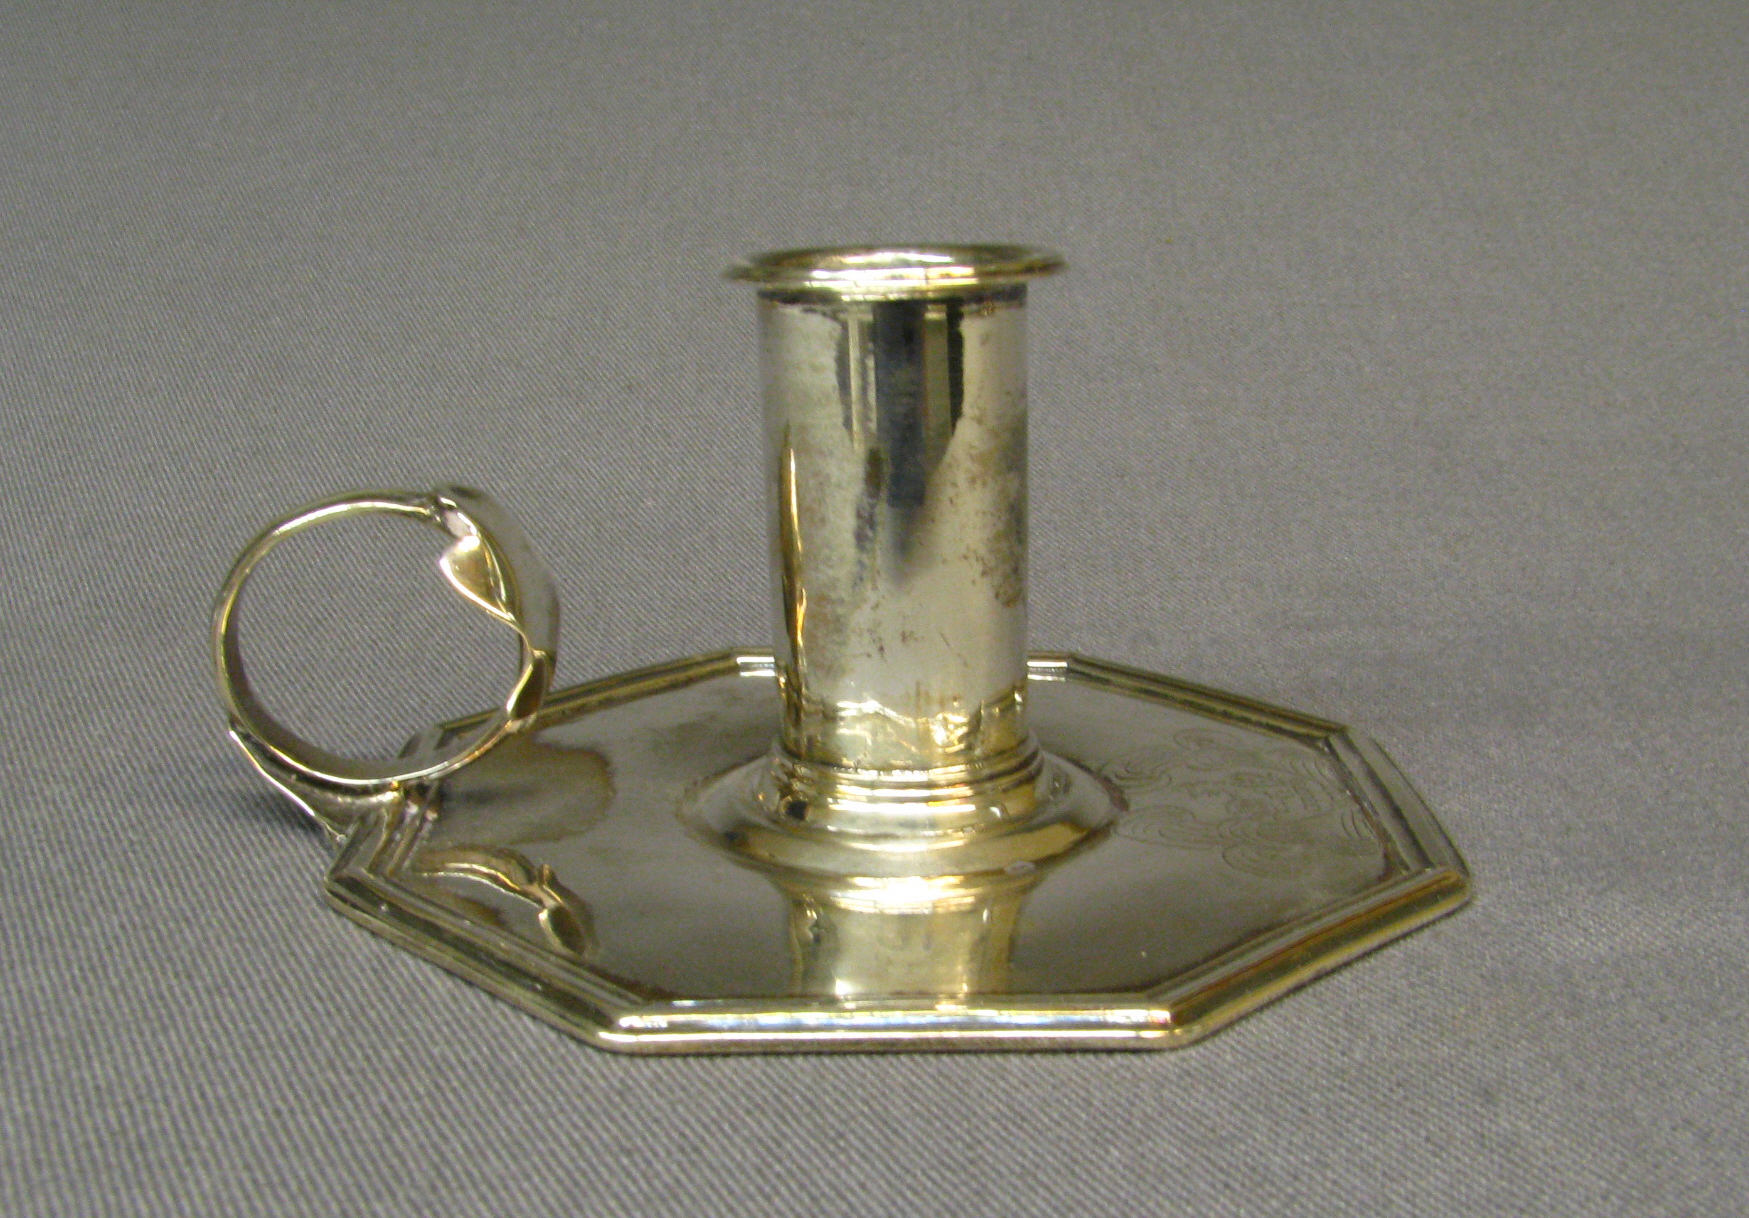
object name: chamber candlestick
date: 1670-1680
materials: silver